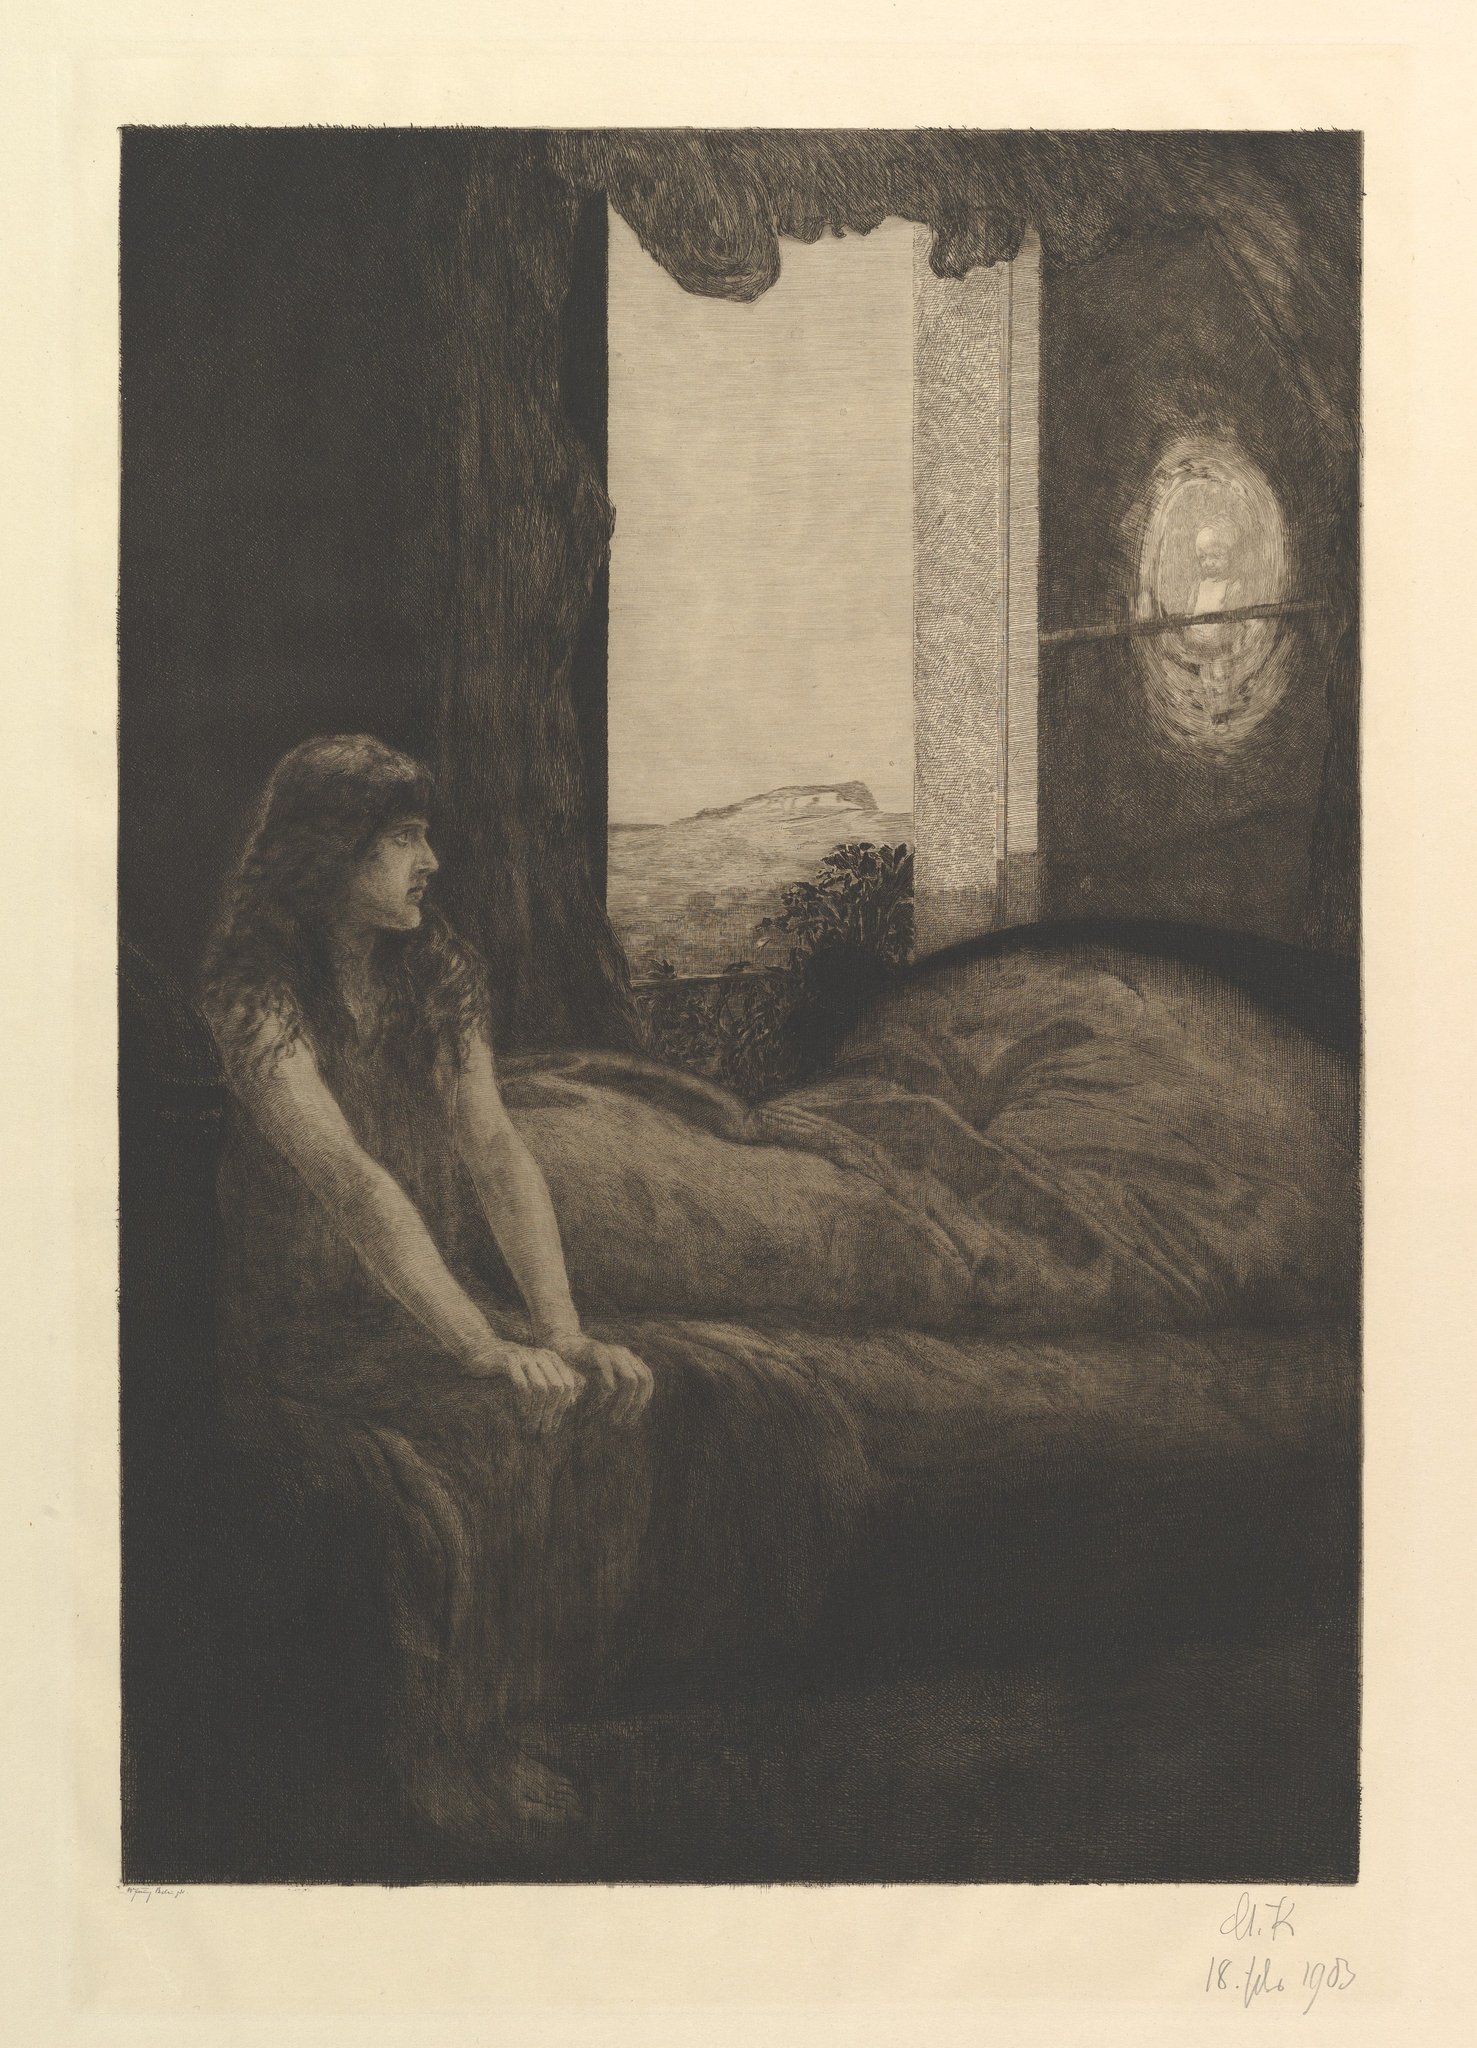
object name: print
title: Awakening (from the series A Love)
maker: max klinger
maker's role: artist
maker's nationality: german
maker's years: 1857-1920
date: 1887-1903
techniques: engraving, etching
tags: women